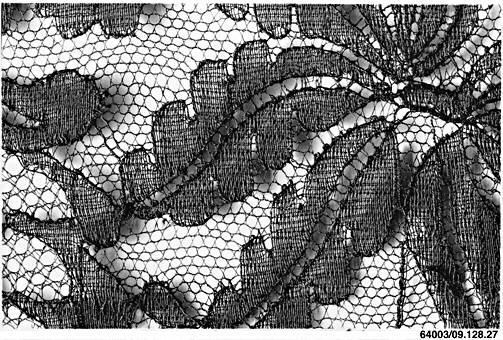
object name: mantilla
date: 1801-1900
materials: cotton